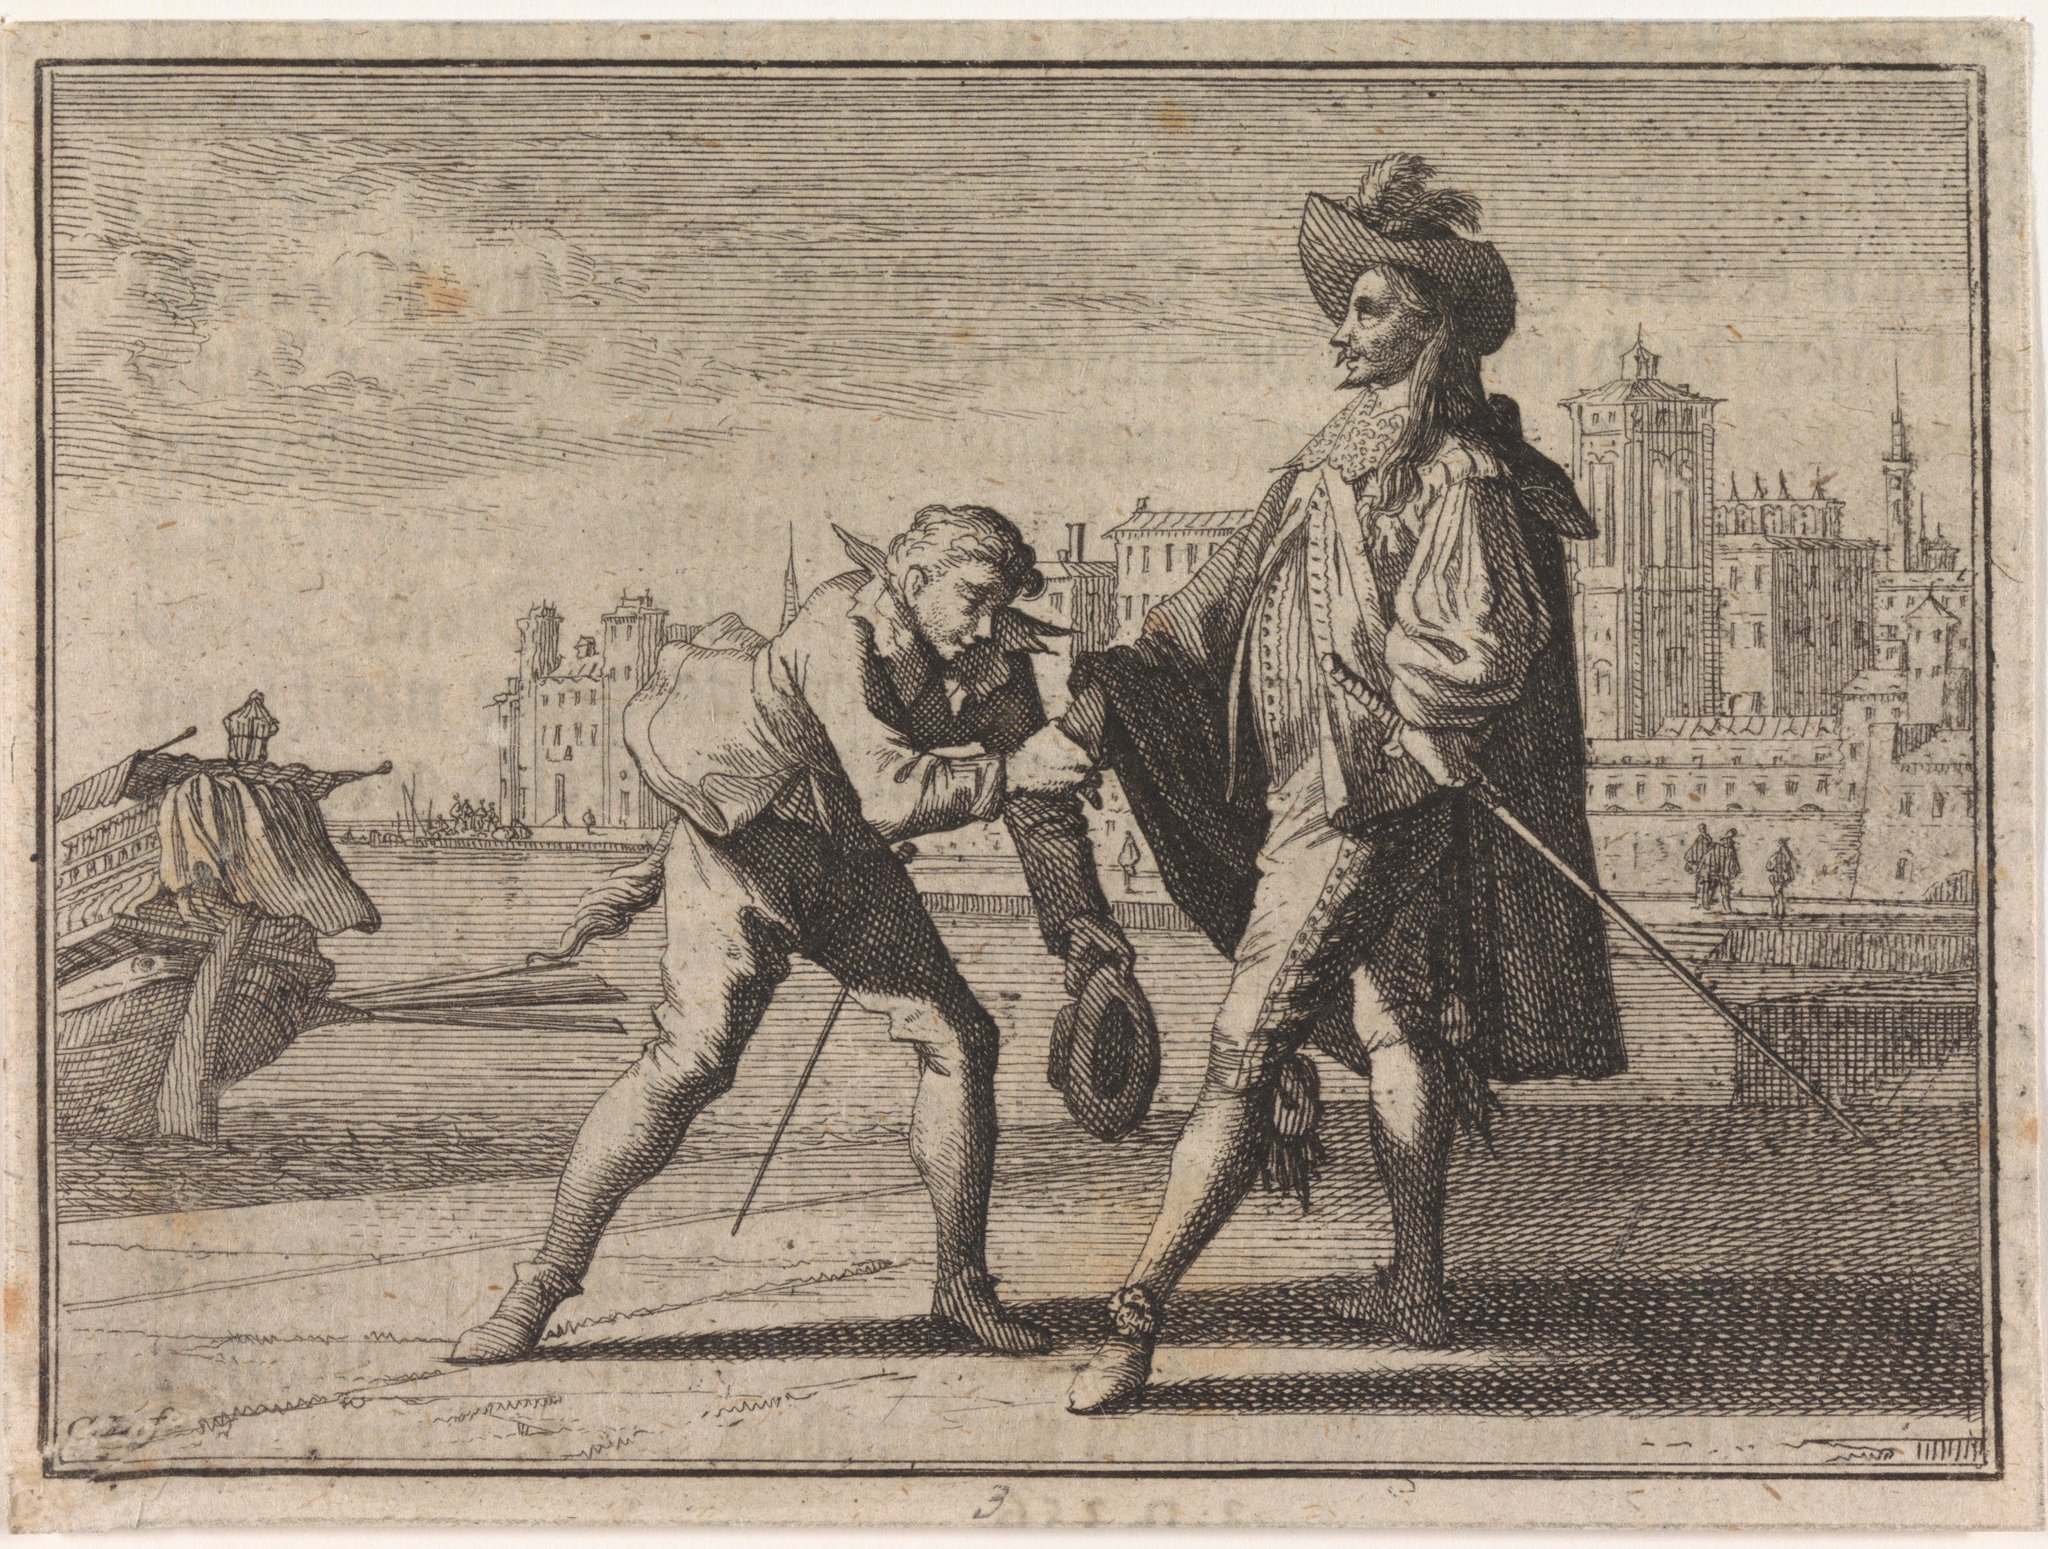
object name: print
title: Die Stimm im Wald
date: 1710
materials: paper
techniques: etching, letterpress printing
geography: nuremberg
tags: pier, quay, wharf, kissing the hand (lovers)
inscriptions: collector's mark: Lugt 2228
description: Illustratie uit: Abraham a Sancta Clara. Heilsames Gemisch Gemasch, das ist: Allerley seltsame und verwunderliche Geschichten (...). Neurenberg: Christoph Weigel, 1710, p. 20.